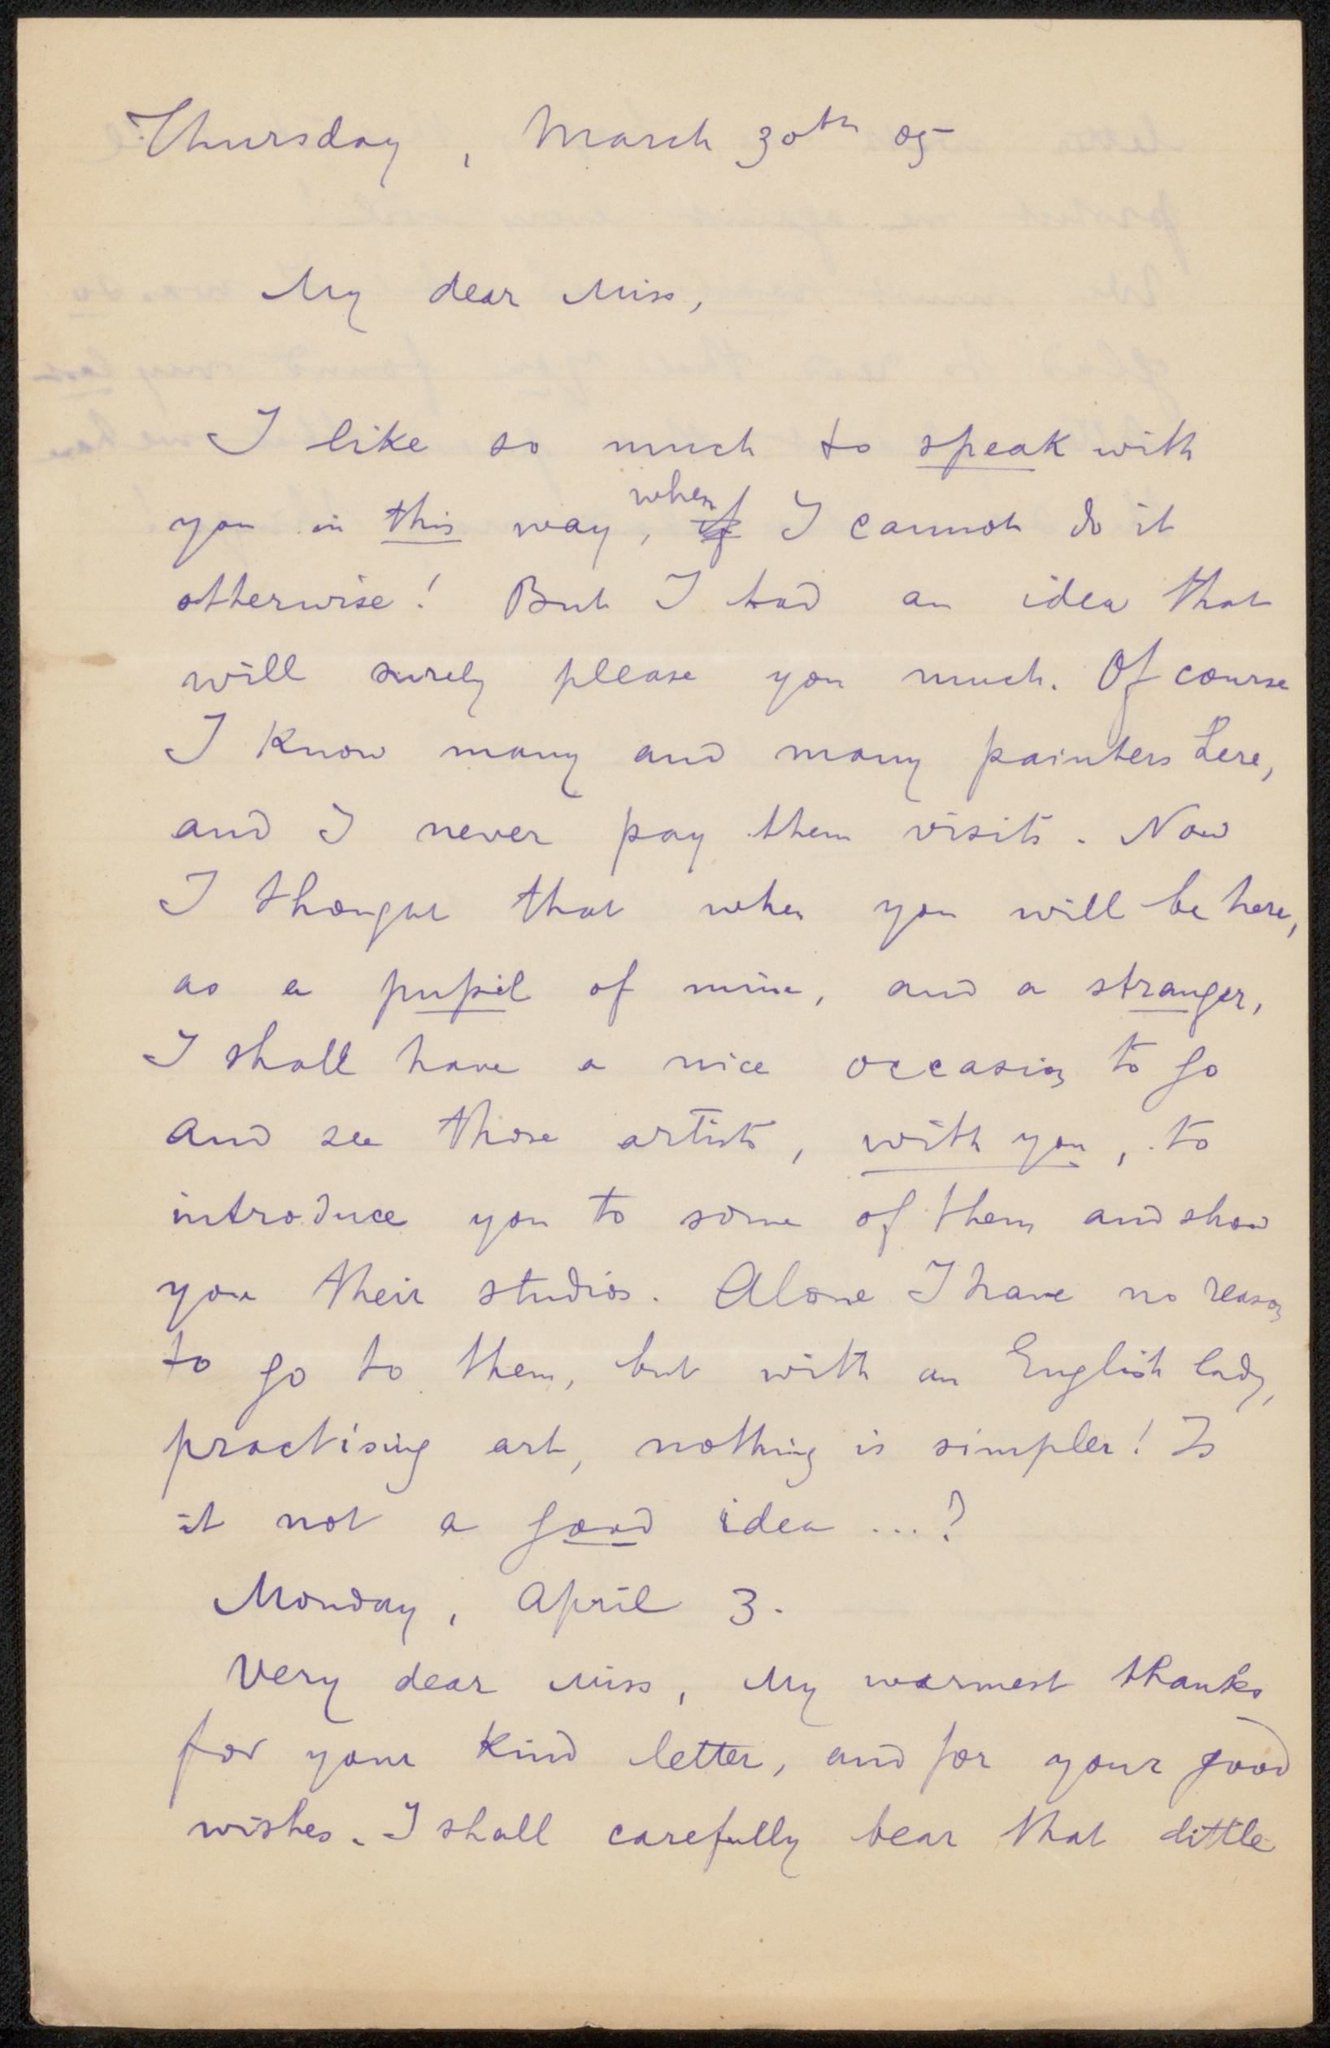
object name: letter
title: Brief aan Elsie Maud Cownie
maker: philip zilcken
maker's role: draughtsman, painter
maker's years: 1857-1930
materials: ink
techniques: pen, writing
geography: venice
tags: voorburg, renée hélène laure zilcken, manchester, the hague, draughtsman, elsie maud cownie, travelling; tourism, education, tuition of the artist (in general), workshop, studio of the artist (in general), italy, paris, venice, bruges, switzerland